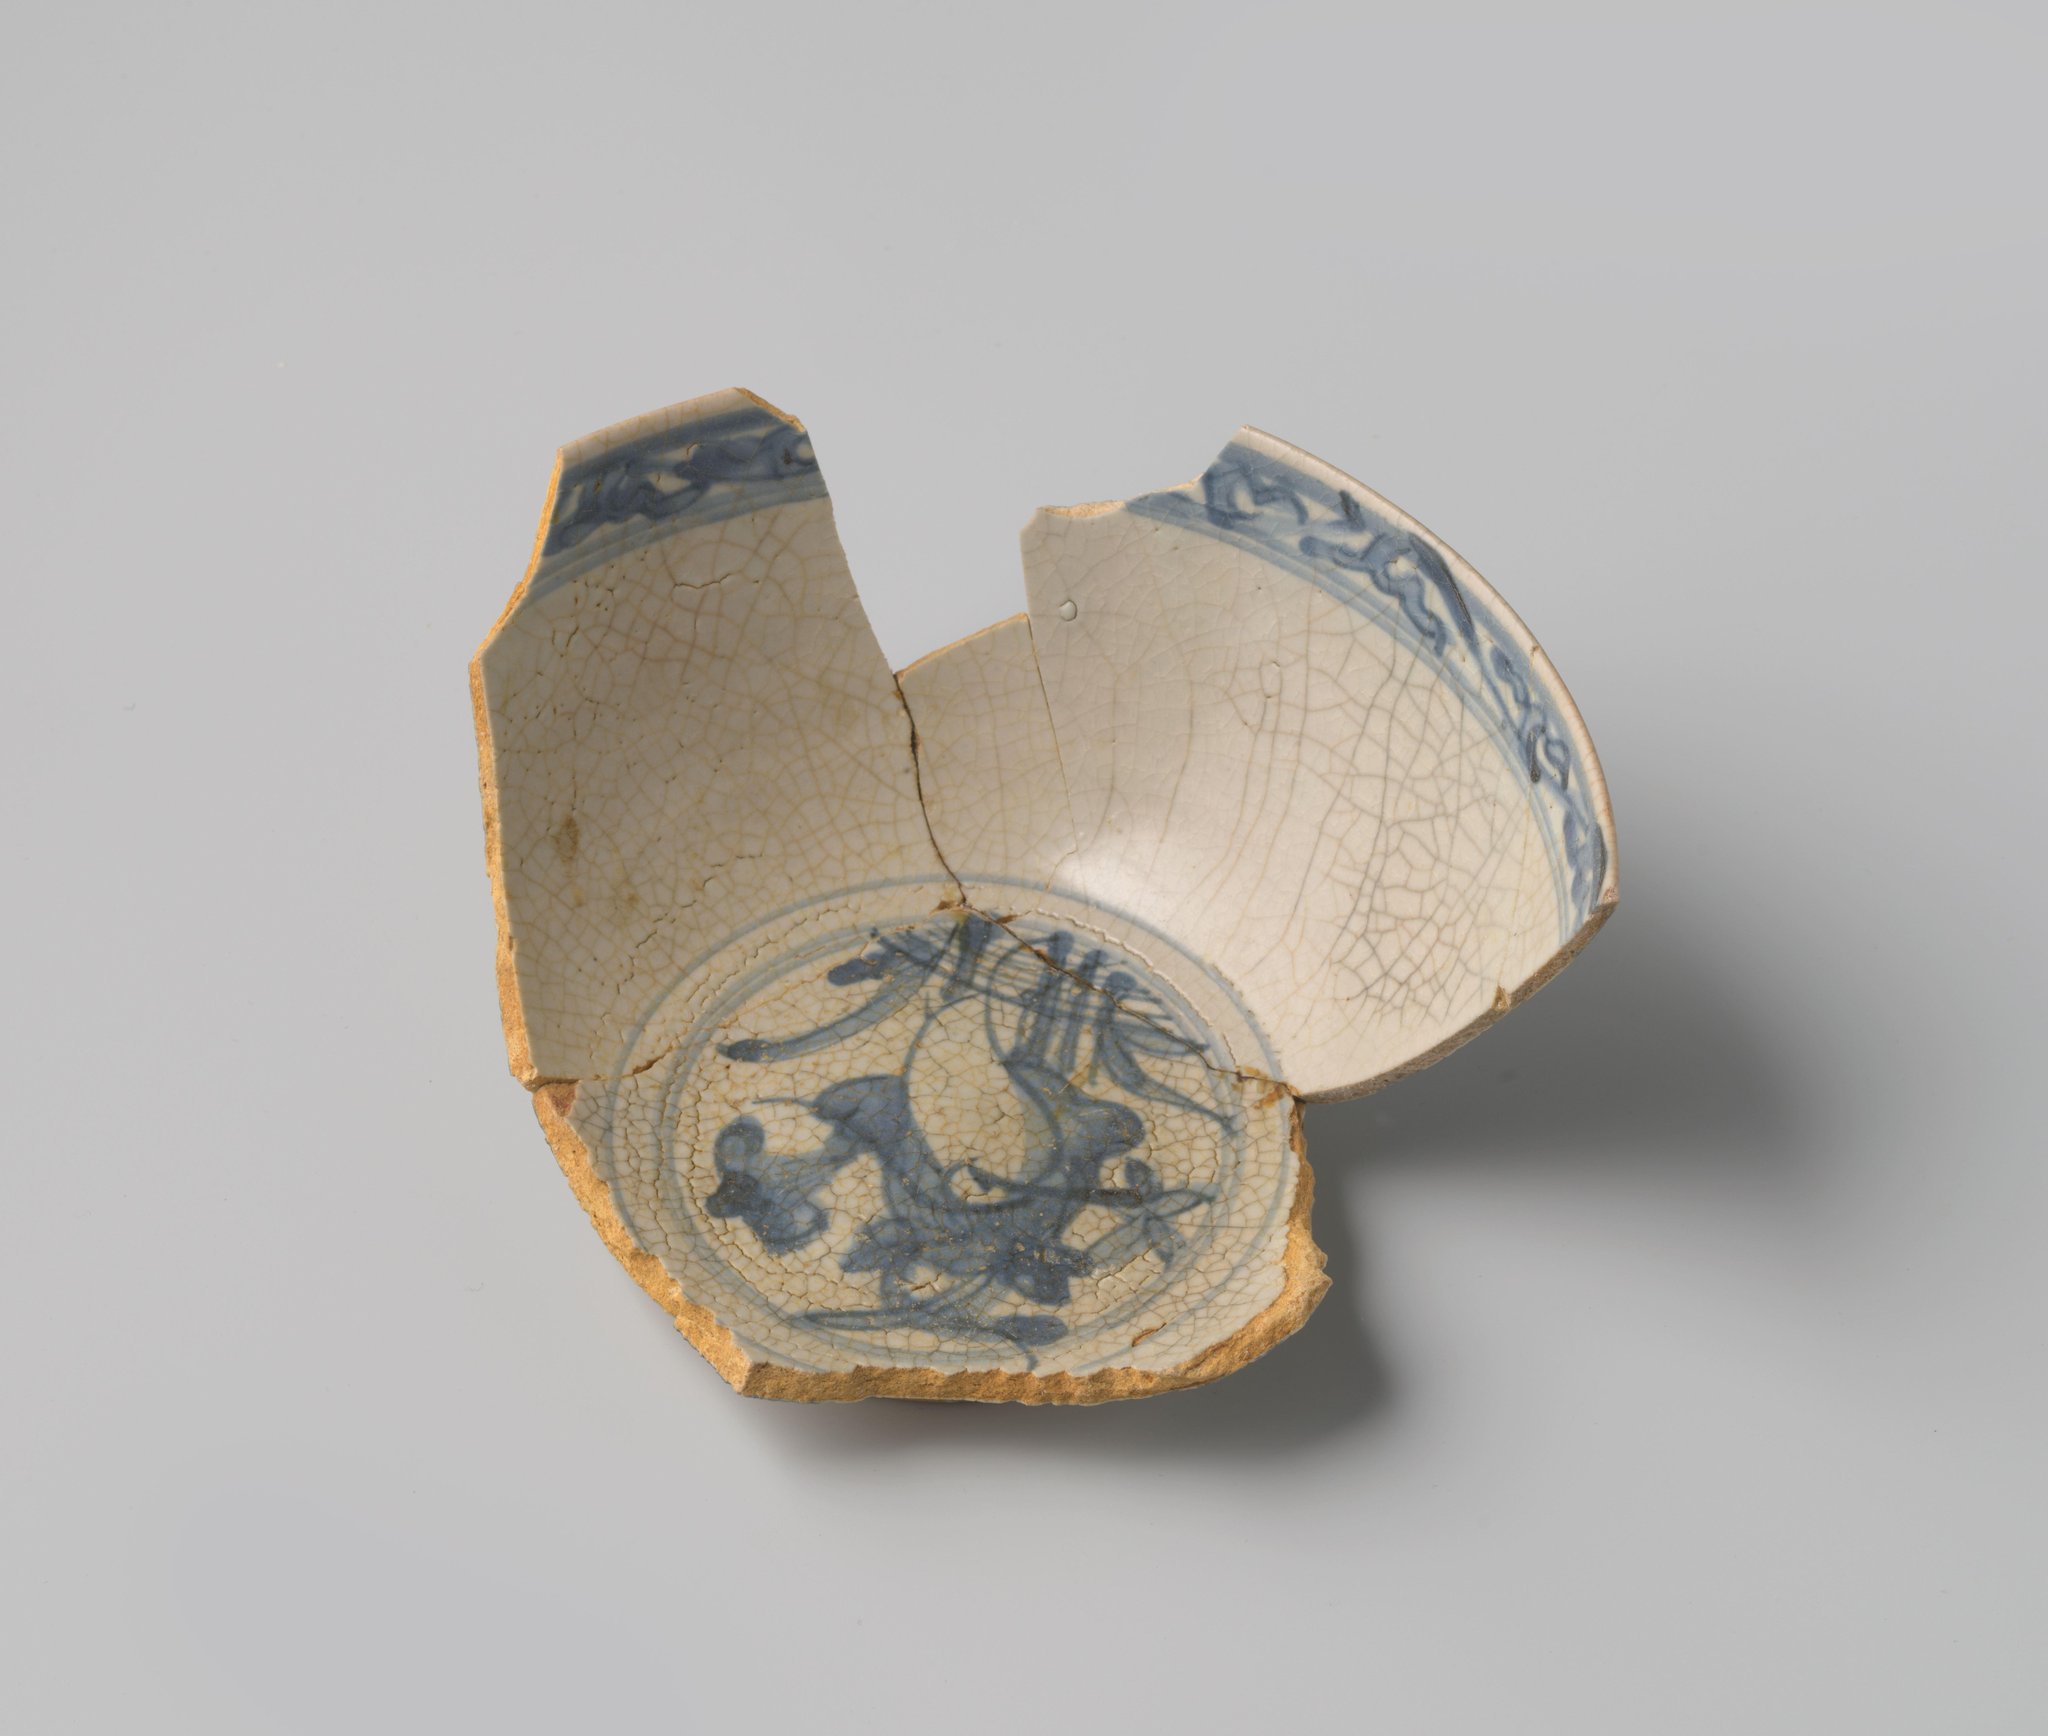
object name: bowl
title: Fragment kom uit V.O.C.-schip de 'Witte Leeuw'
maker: Anonymous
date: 1613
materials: porcelain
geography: shantou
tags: verenigde oostindische compagnie, sint-helena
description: A bowl. In the centre there is a standing crane among grass. Around the lip-rim a sketchy design of leaves. On the outside a pond landscape, 4 groups of ducks are drawn, one under the other, with a large lotus leaf and pond weeds in between.